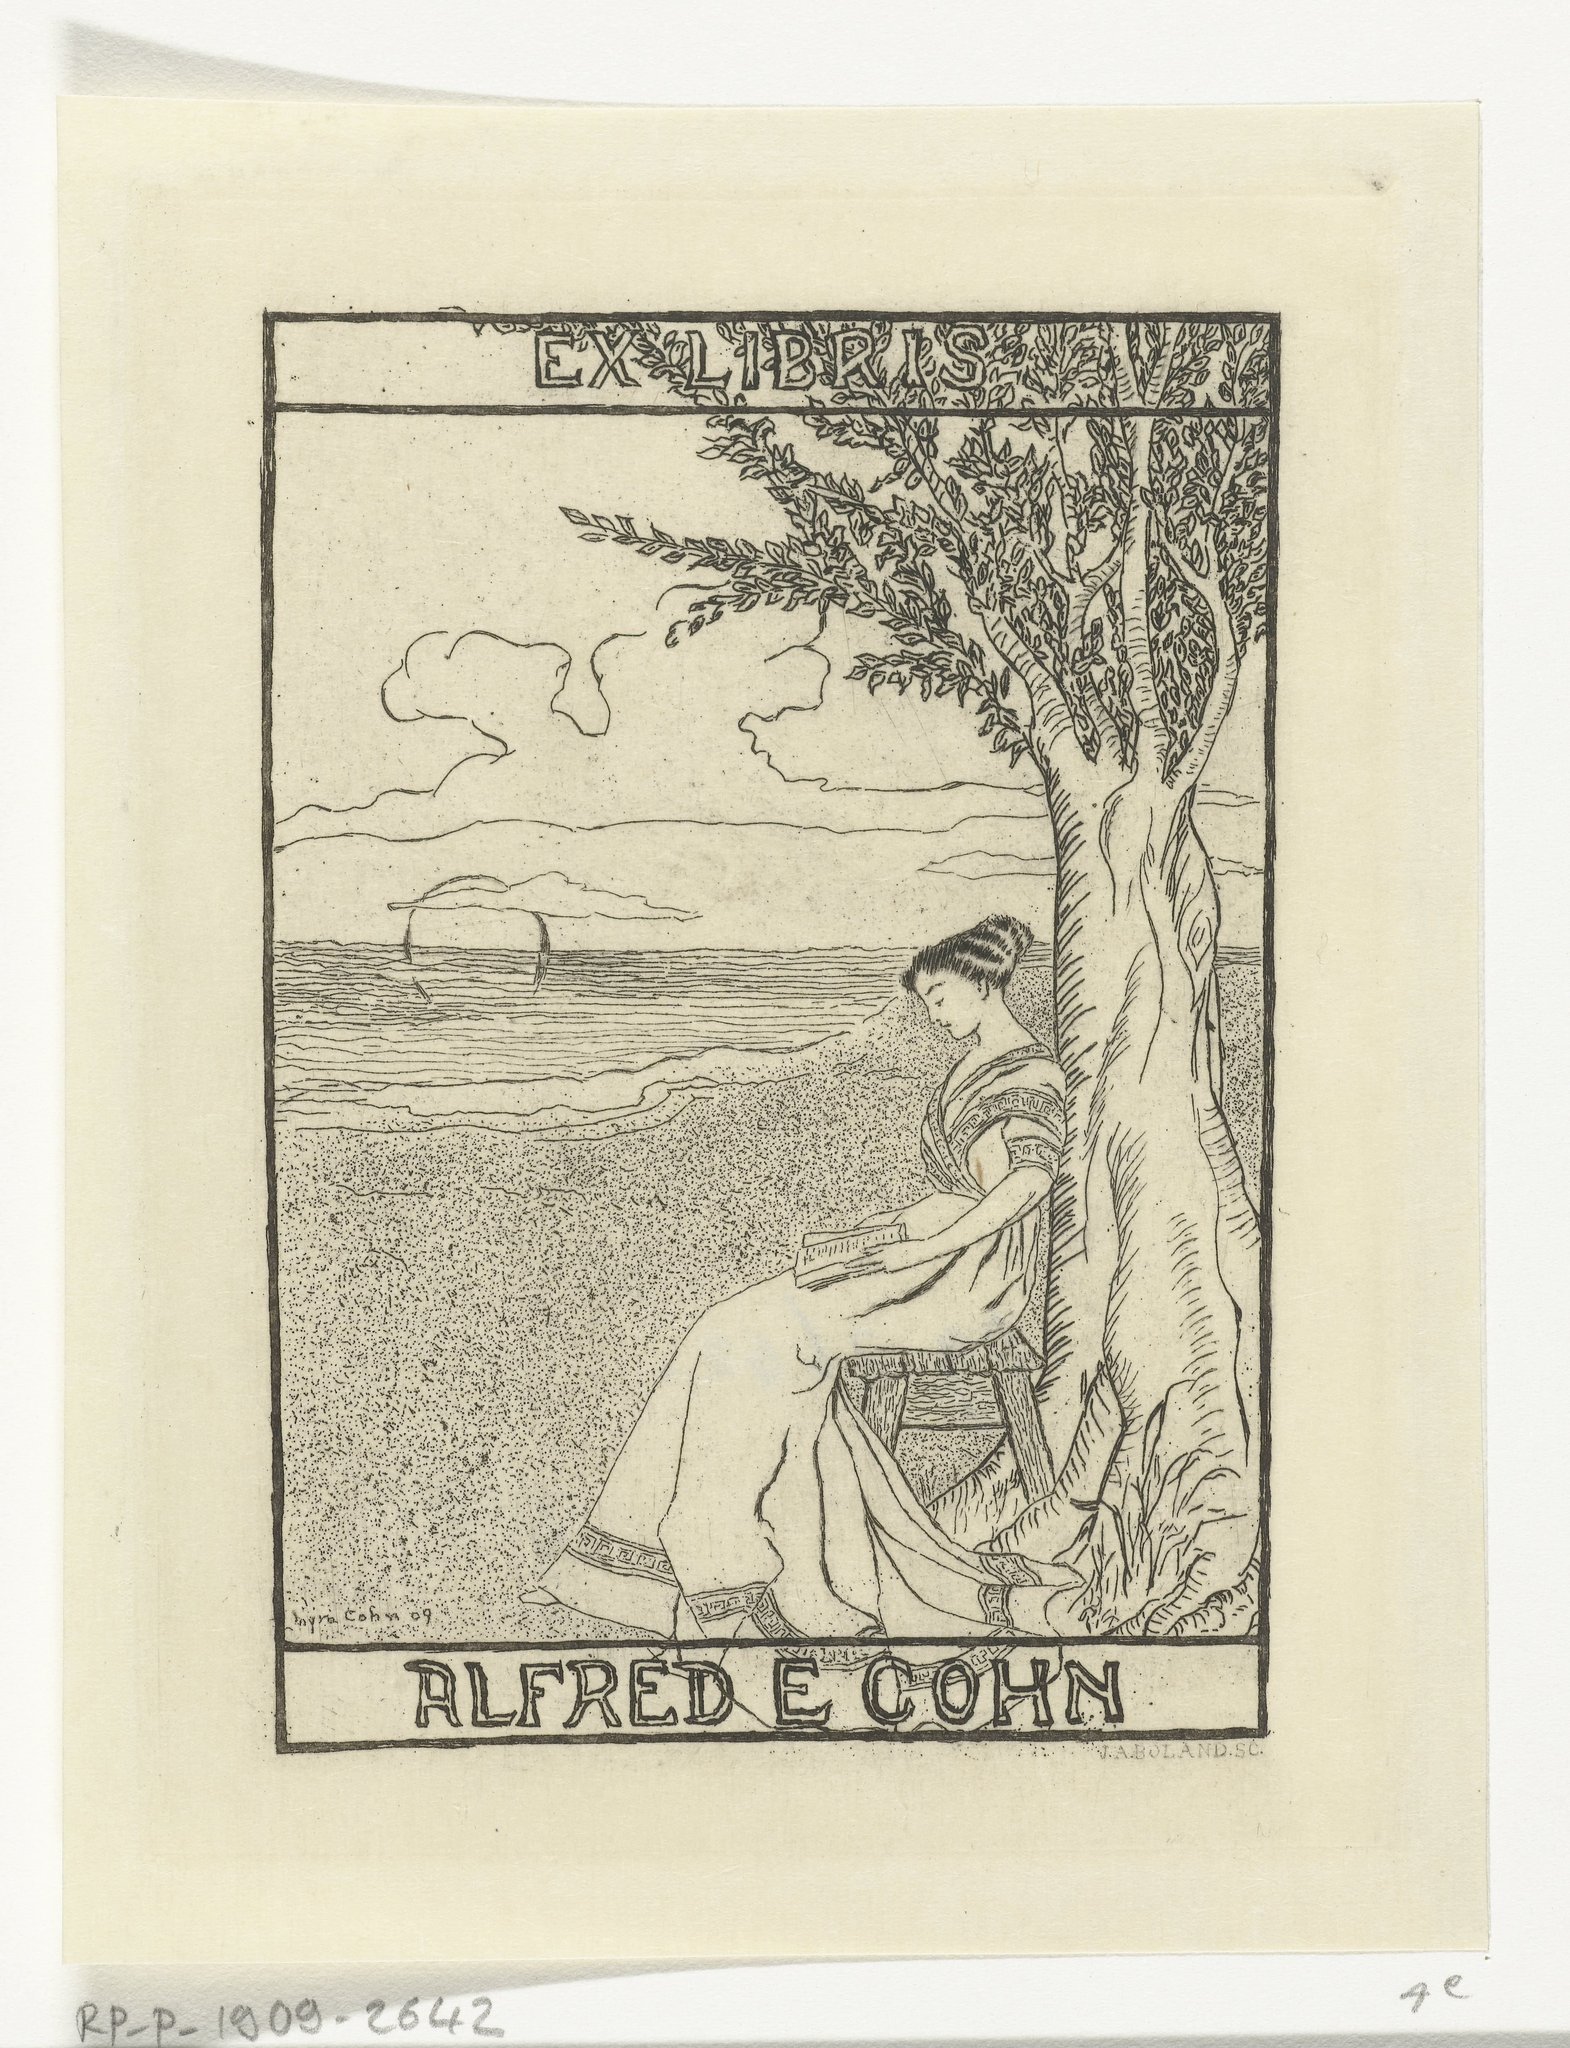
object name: print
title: Ex libris van Alfred E. Cohn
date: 1909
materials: paper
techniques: etching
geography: amsterdam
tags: reading, ex-libris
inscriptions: collector's mark: Lugt 2228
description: Een jonge vrouw zit lezend onder een boom. De zon gaat net onder in de zee.